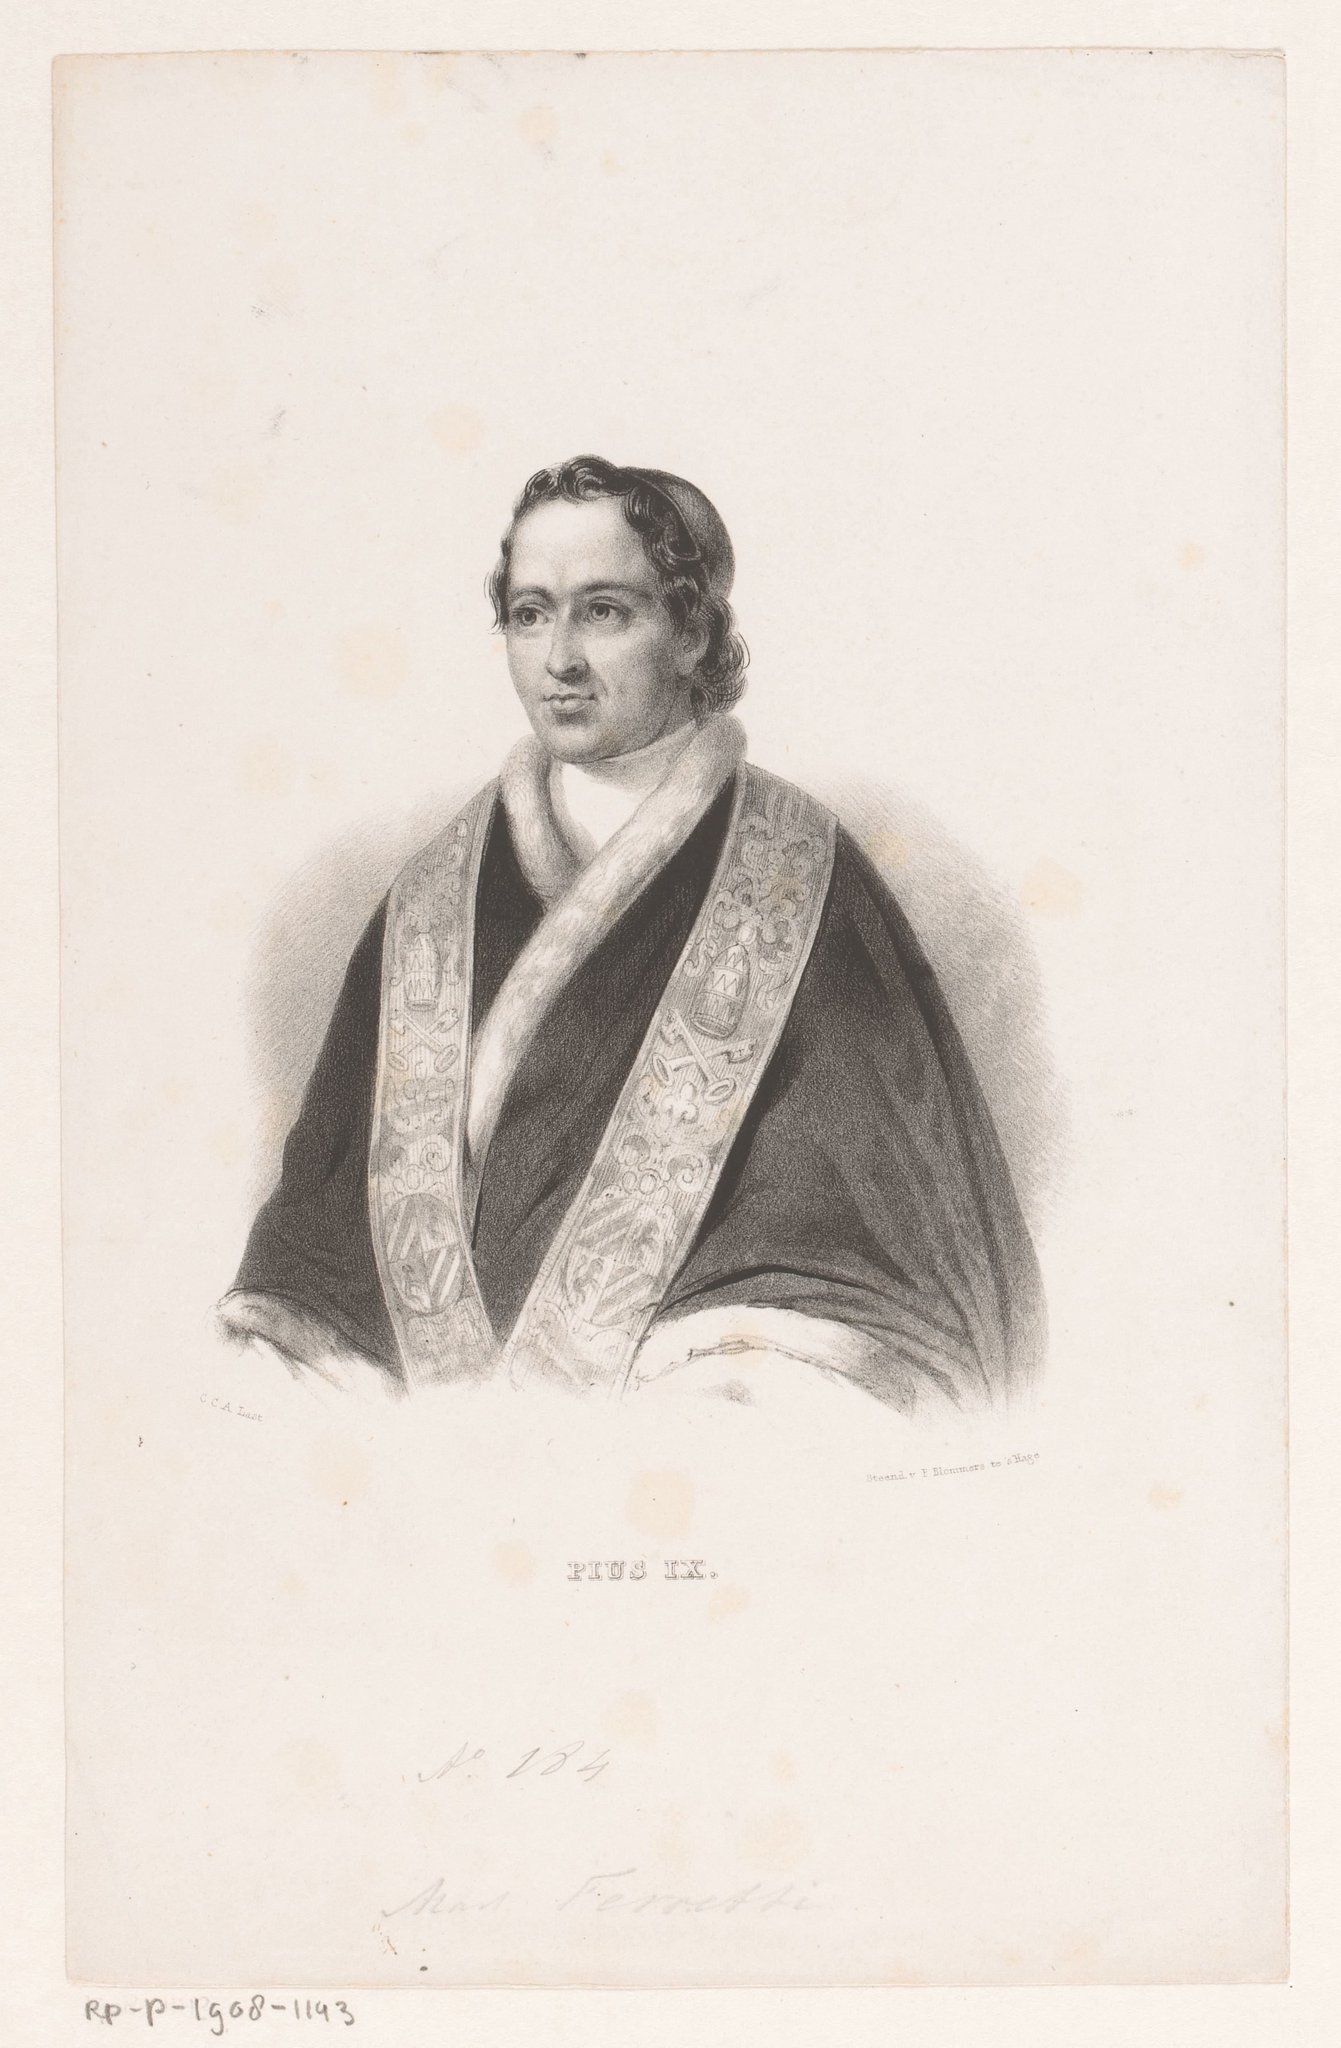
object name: print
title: Portret van paus Pius IX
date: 1842-1887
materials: paper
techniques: lithograph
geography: the hague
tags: rome, historical persons (+ (full) bust portrait), stole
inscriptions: collector's mark: Lugt 2228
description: De geportretteerde draagt een solideo en een geborduurde stola.